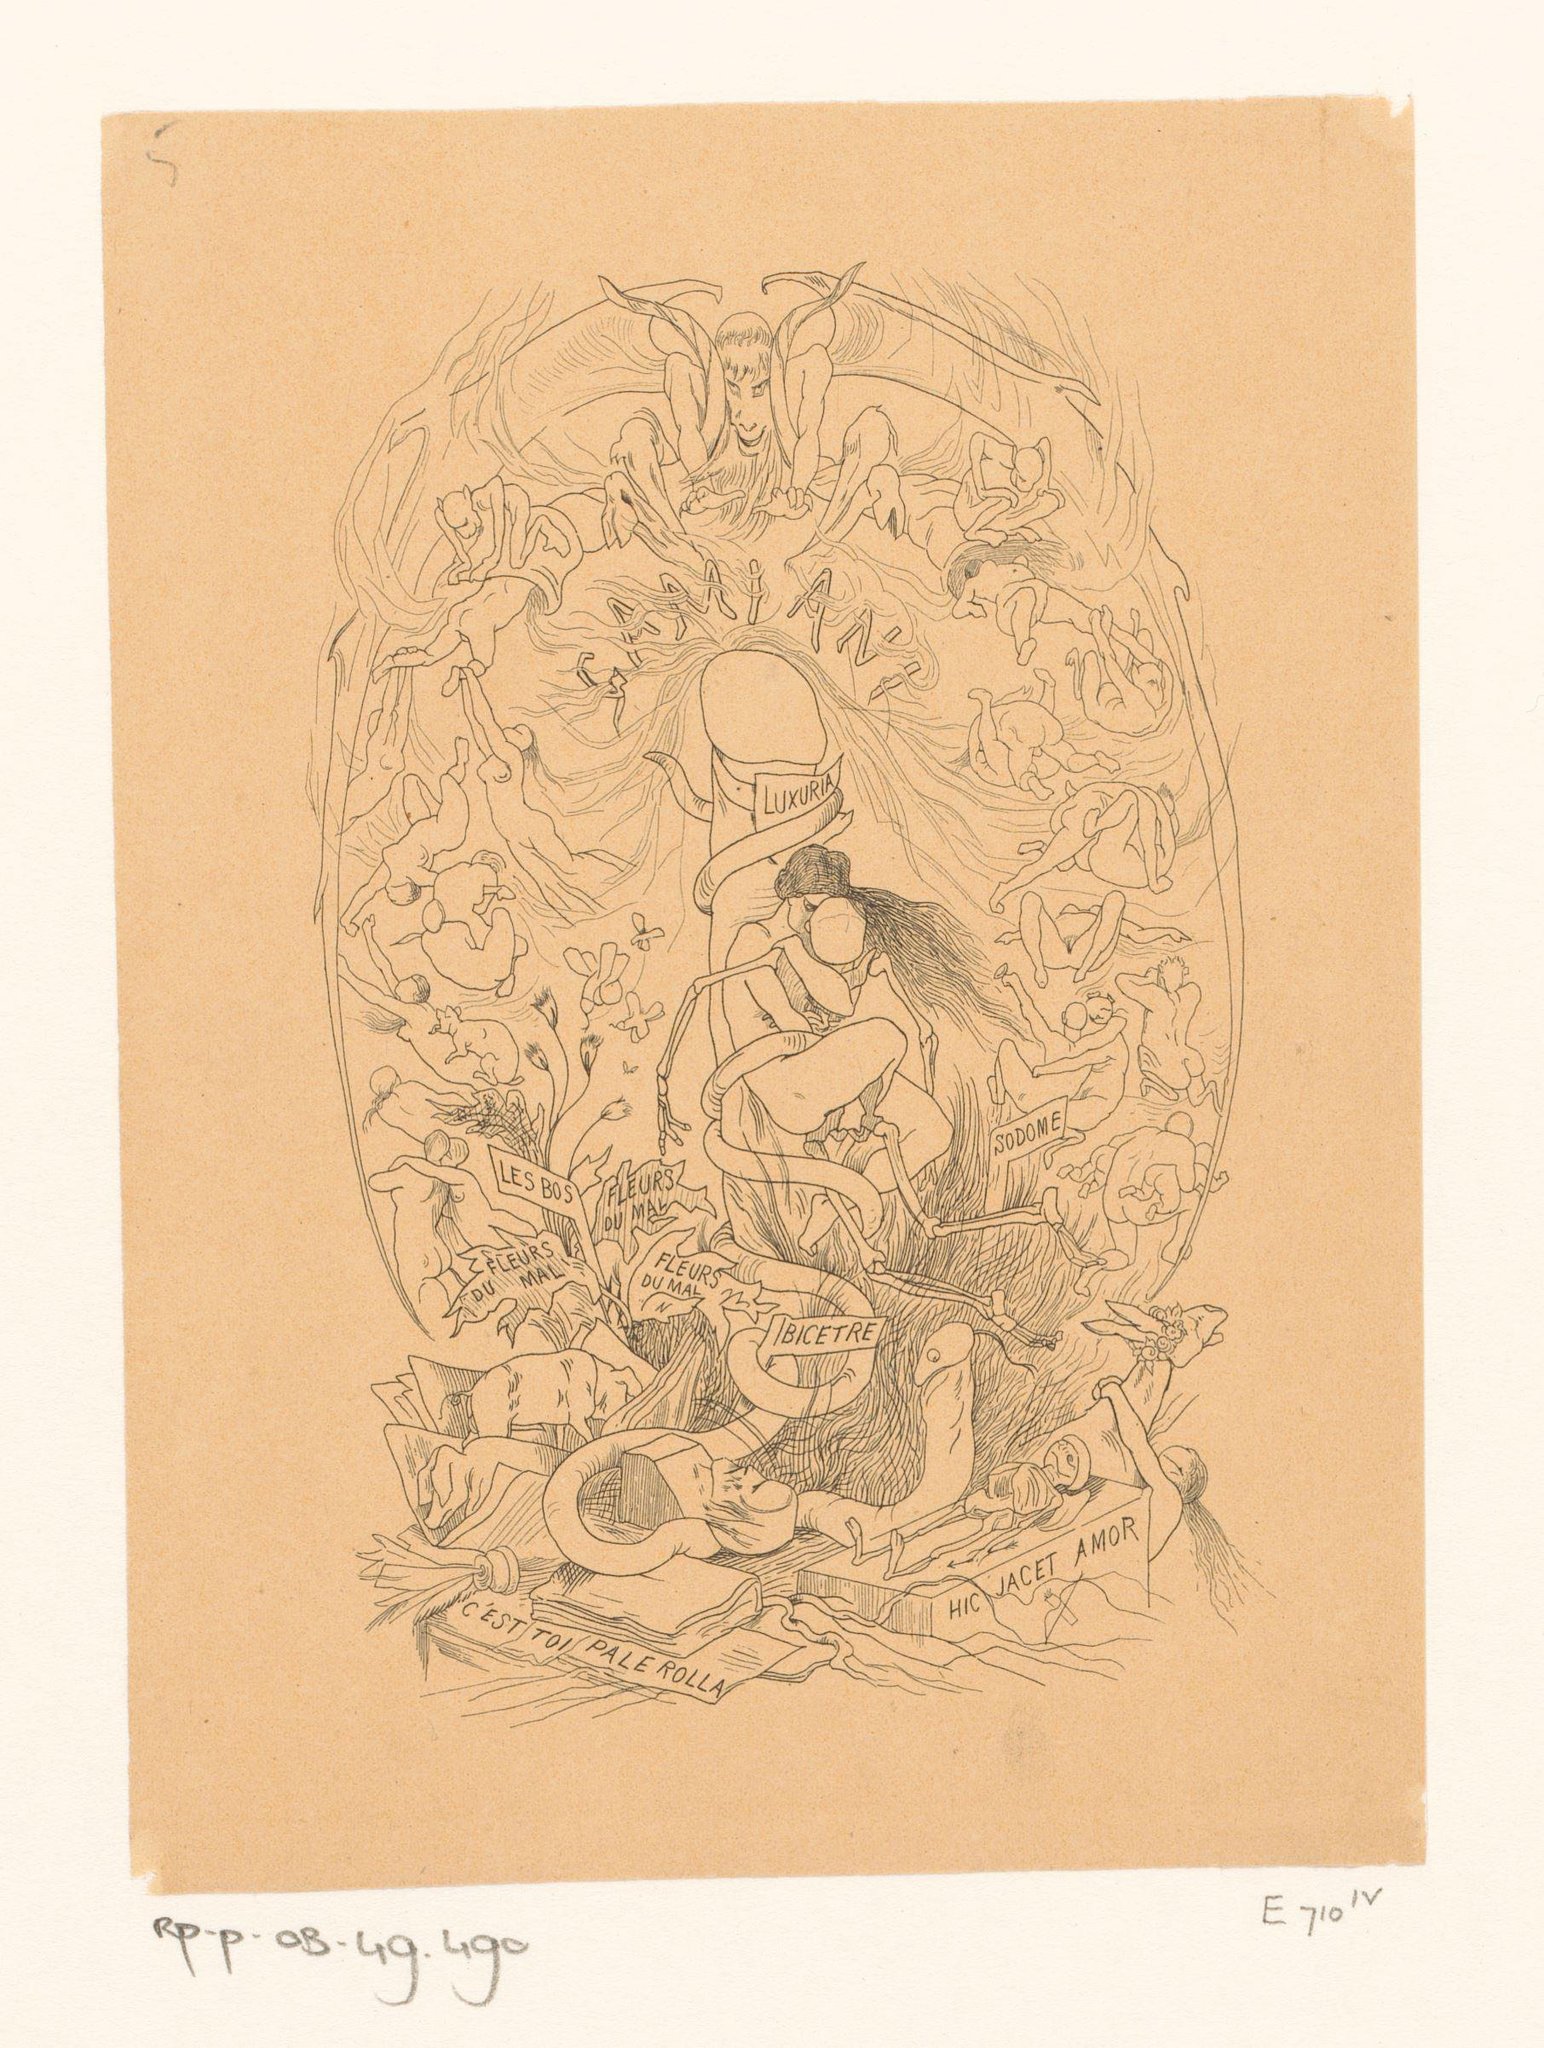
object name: photomechanical print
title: Vrouw in amoureuze omhelzing met een skelet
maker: félicien rops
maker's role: draughtsman, print maker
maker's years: 1833-1898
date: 1864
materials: paper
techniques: photoaquatint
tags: (lovers) kissing each other, (human) skeleton, penis, phallus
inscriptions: collector's mark: Lugt 2228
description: Deze prent is mogelijk de kopie die Rouir noemt. Een eerdere staat van deze prent is gebruikt in: Musset, A. de. Gamiani ou deux nuits d'excès. Parijs: Poulet-Malassis, 1864.